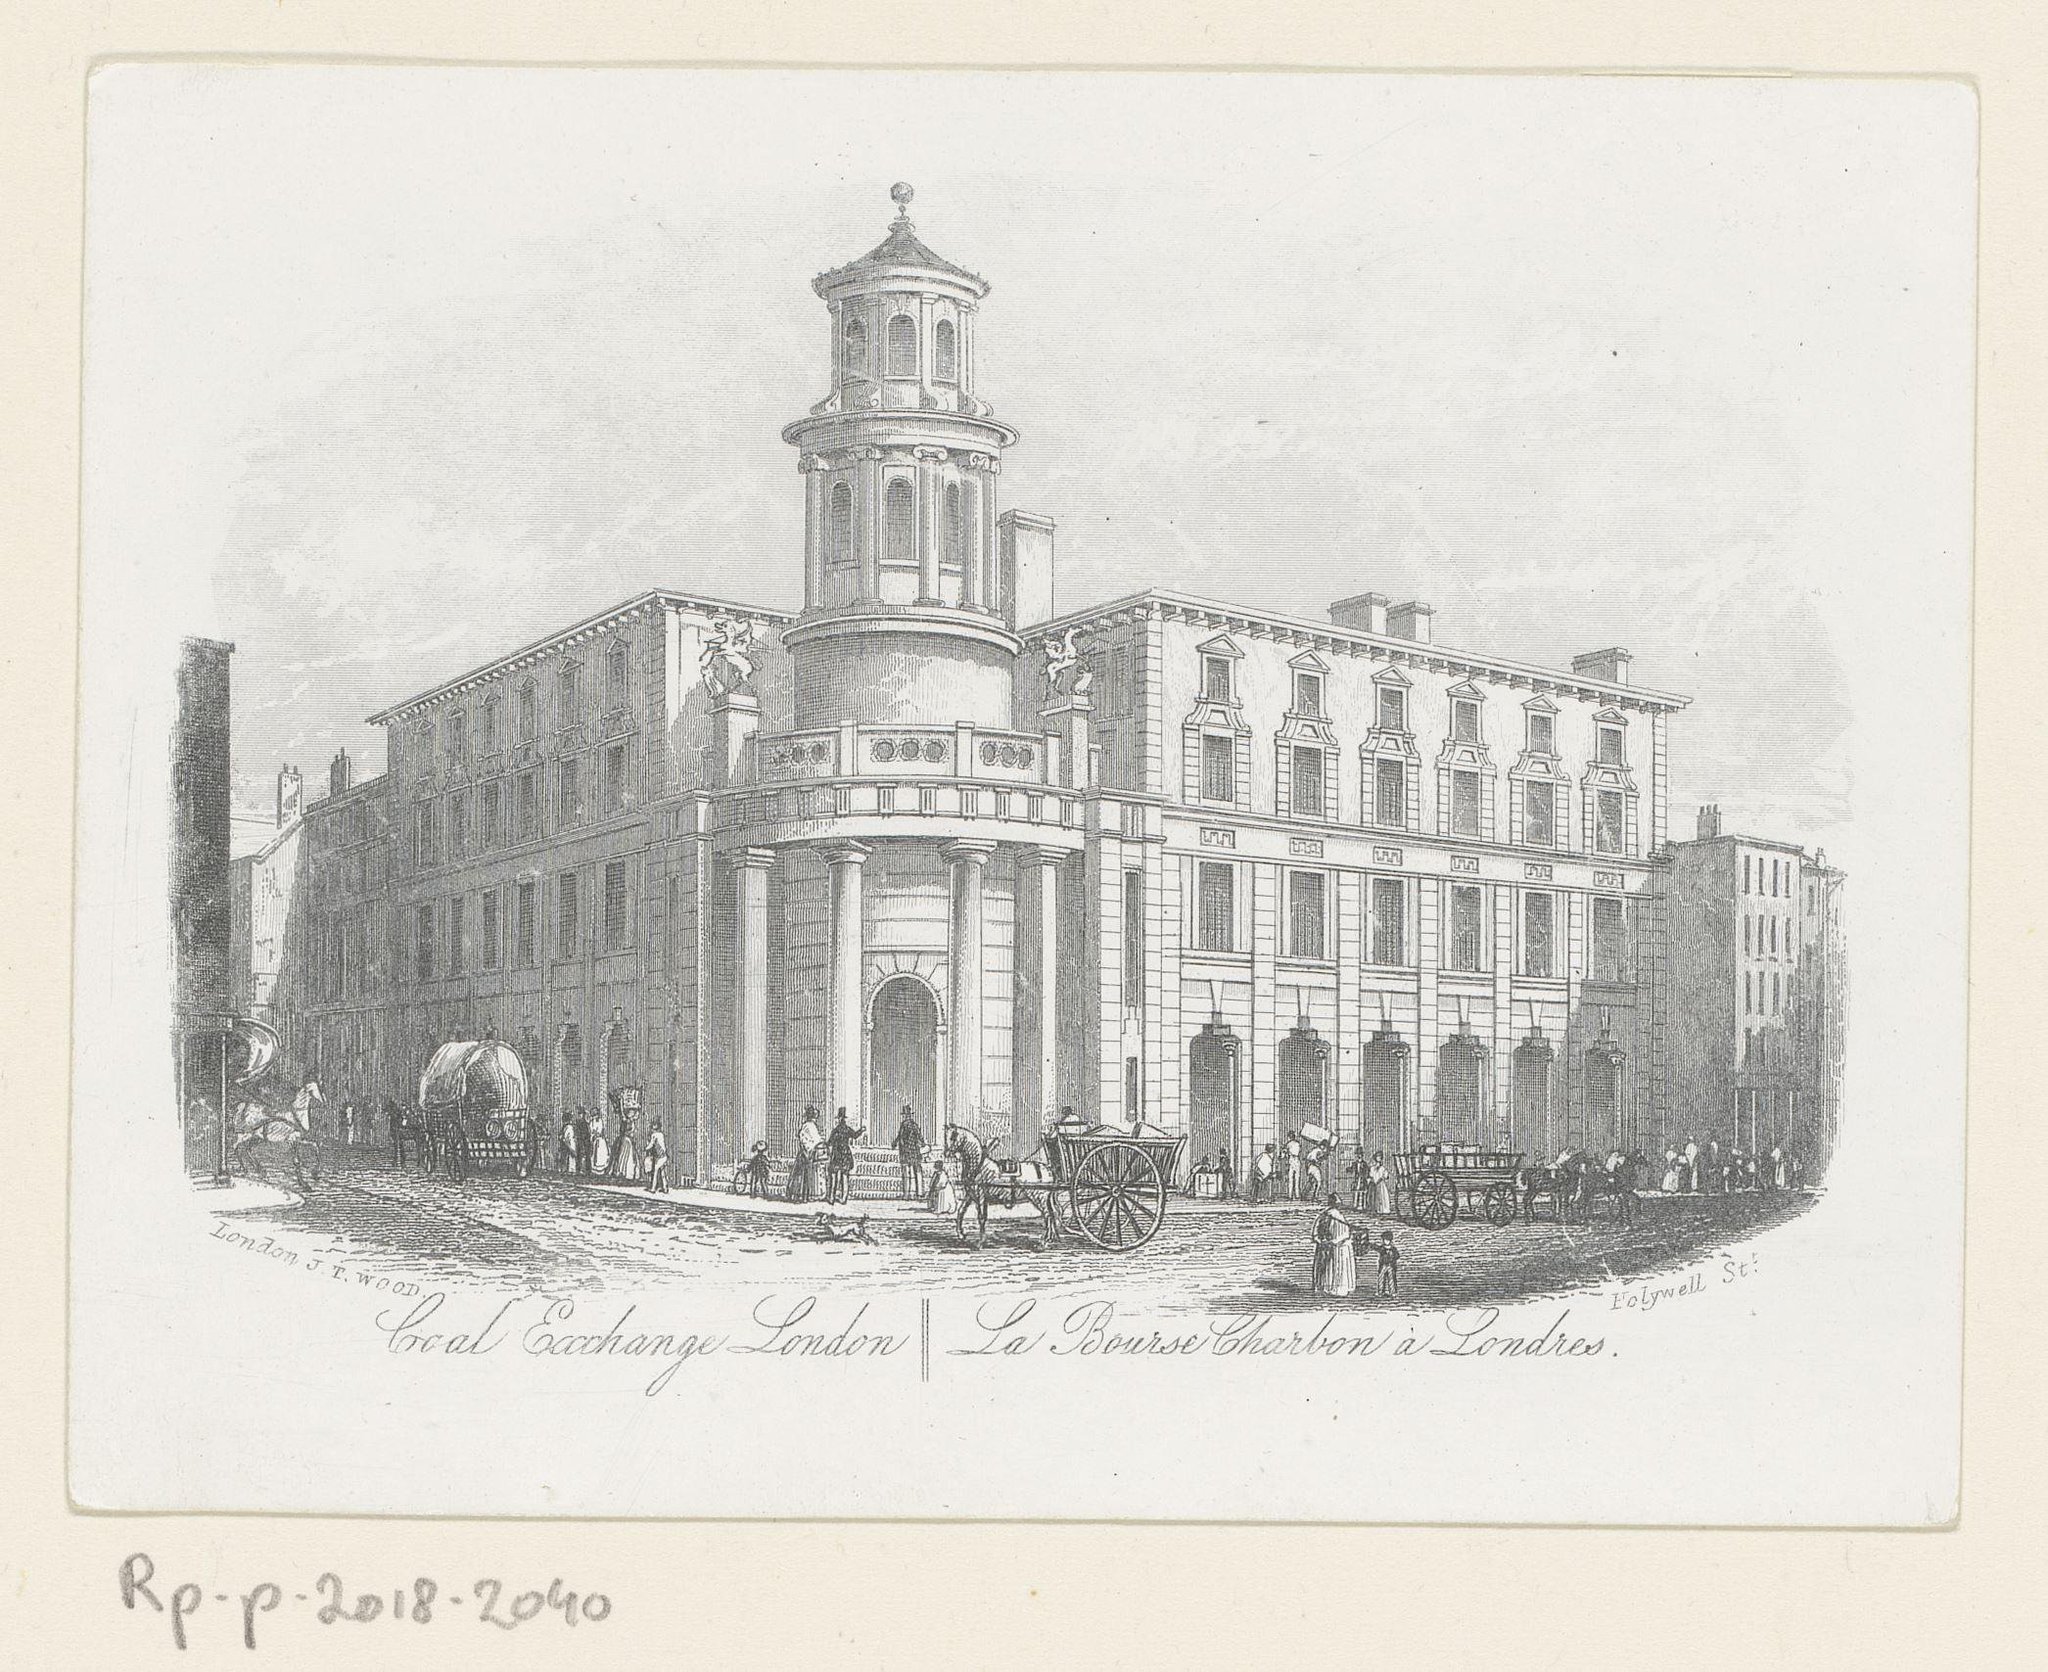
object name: print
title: Coal Exchange London / La Bourse Charbon à Londres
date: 1841-1885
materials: paper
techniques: etching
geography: london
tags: exchange, bourse, london